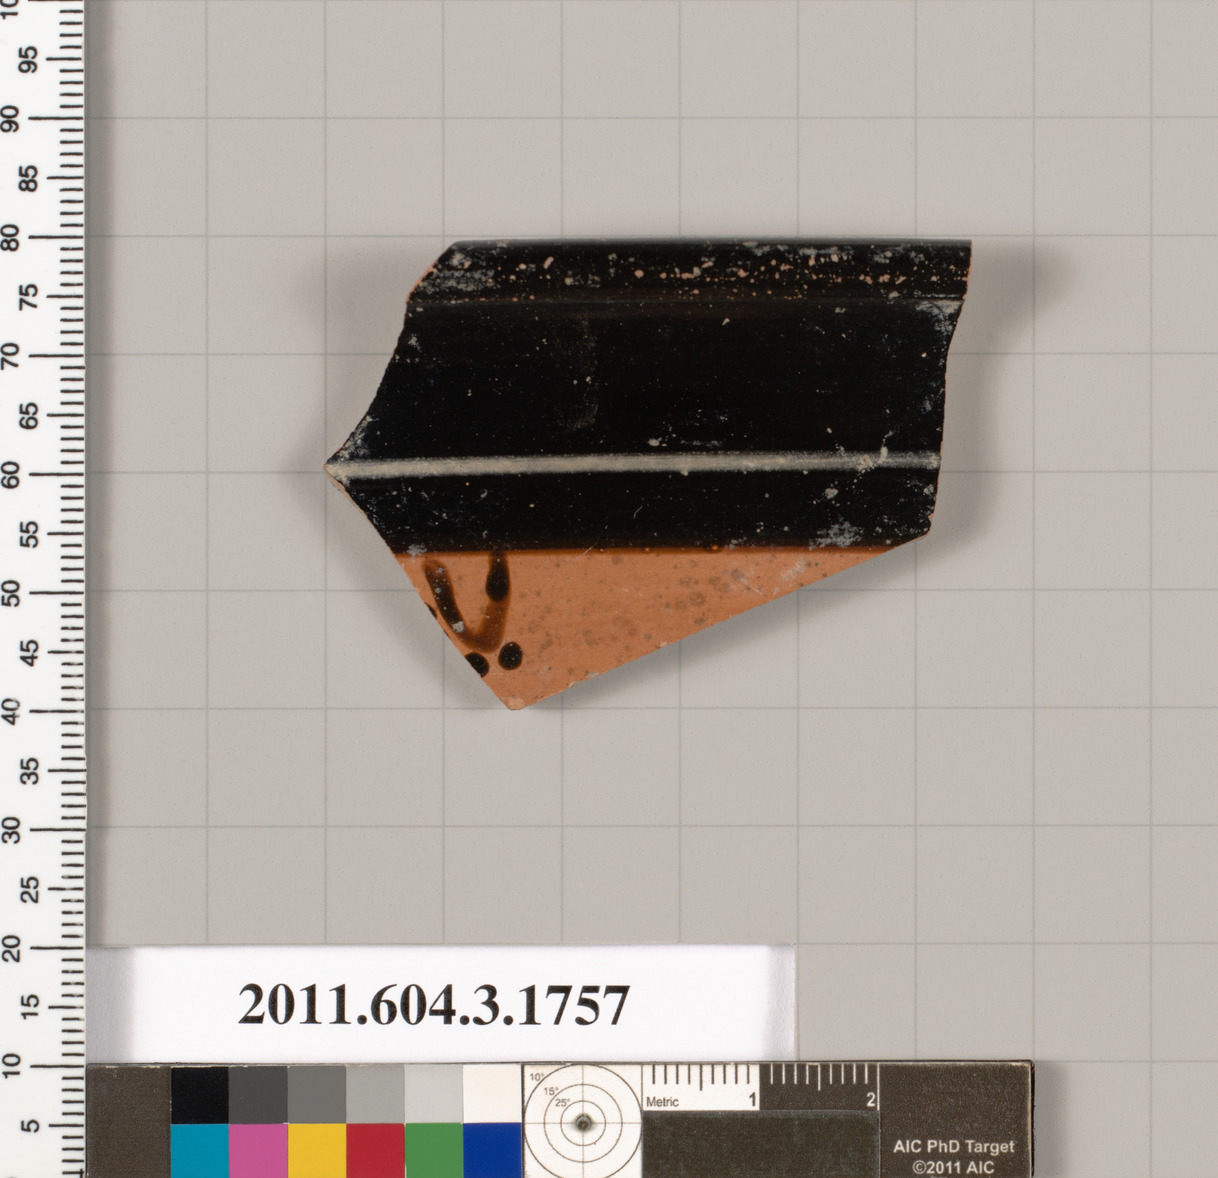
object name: kylix fragment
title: Terracotta rim fragment of a kylix: Band cup (drinking cup)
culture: greek, attic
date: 550-526 BCE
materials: terracotta